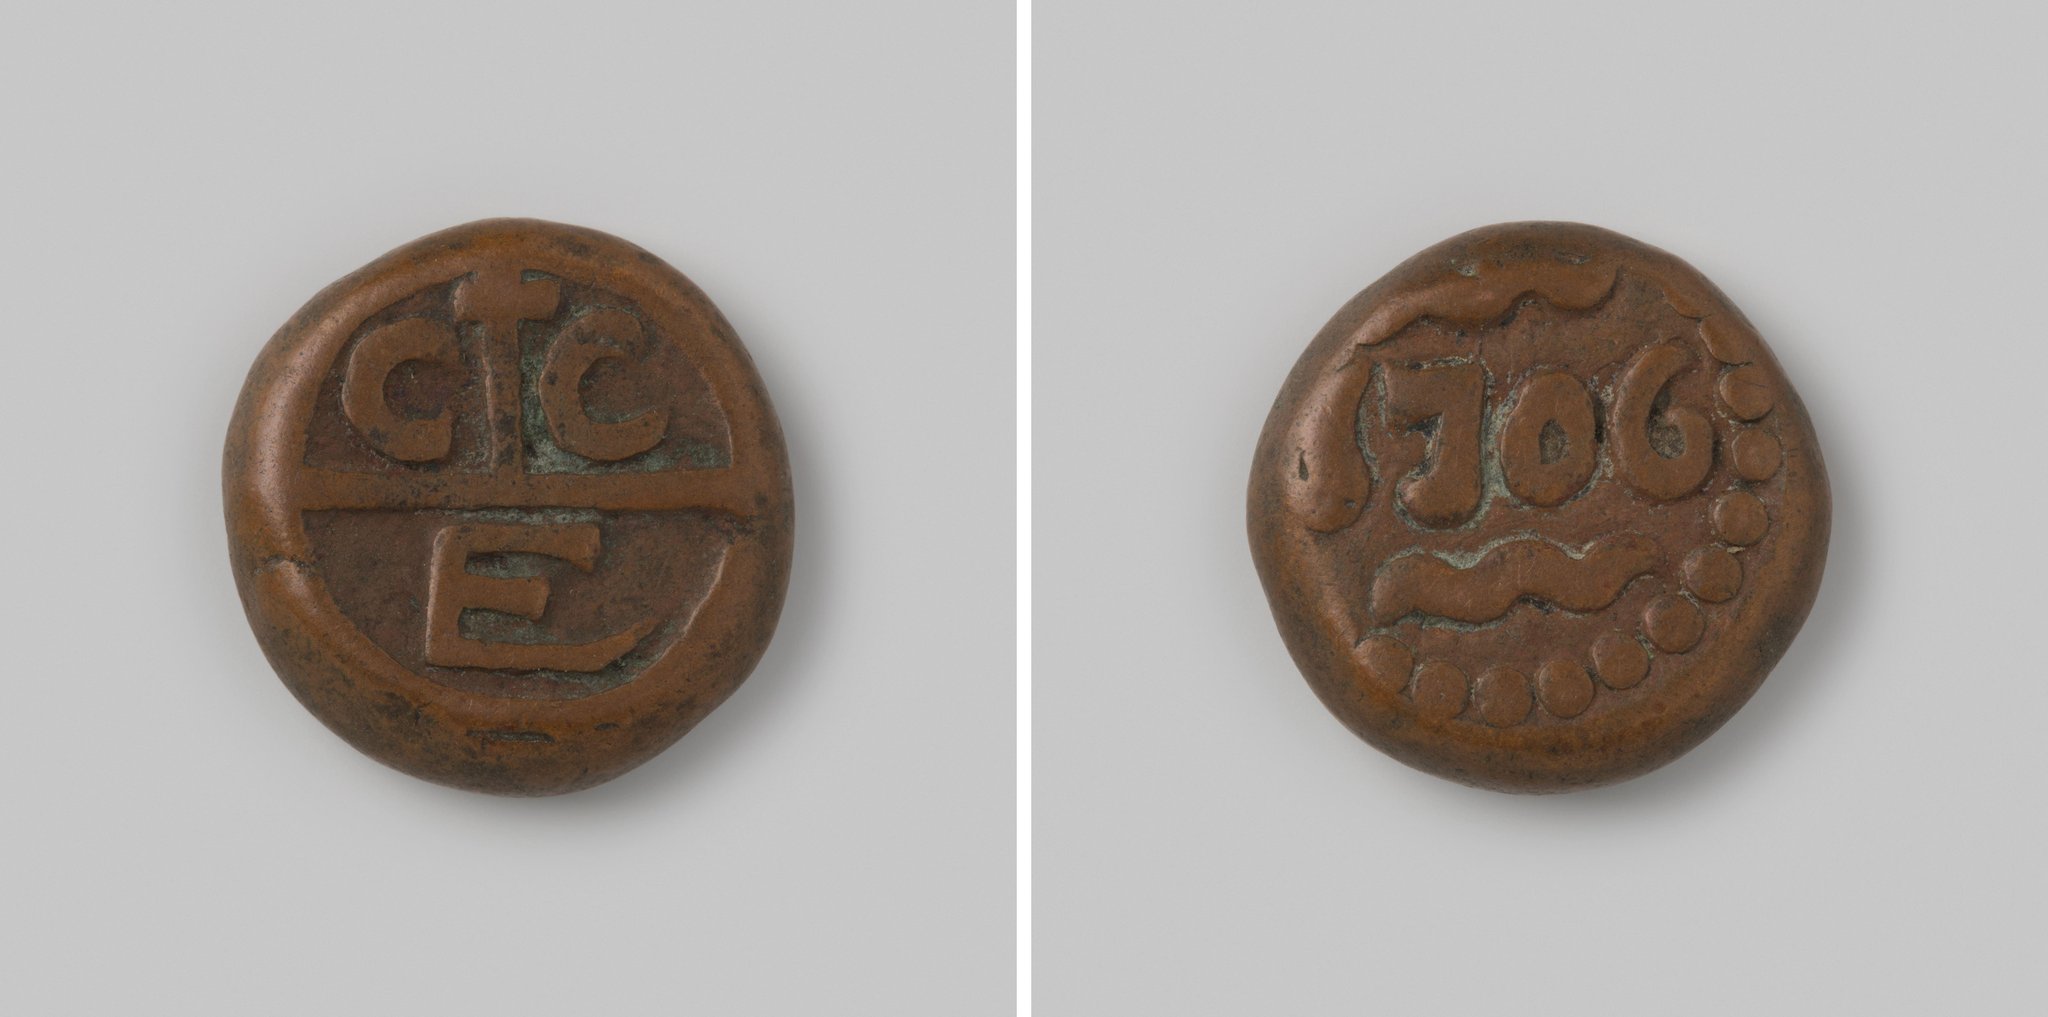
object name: coin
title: Madras, India, Engelse Oostindische Compagnie (EIC), dudu of 10 cash, 1706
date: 1706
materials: copper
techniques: striking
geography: chennai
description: Koperen munt. Voorzijde: merk van de EIC, met de letters G,C en E. Keerzijde: tussen twee golvende lijnen jaartal: 1706. Gladde rand.